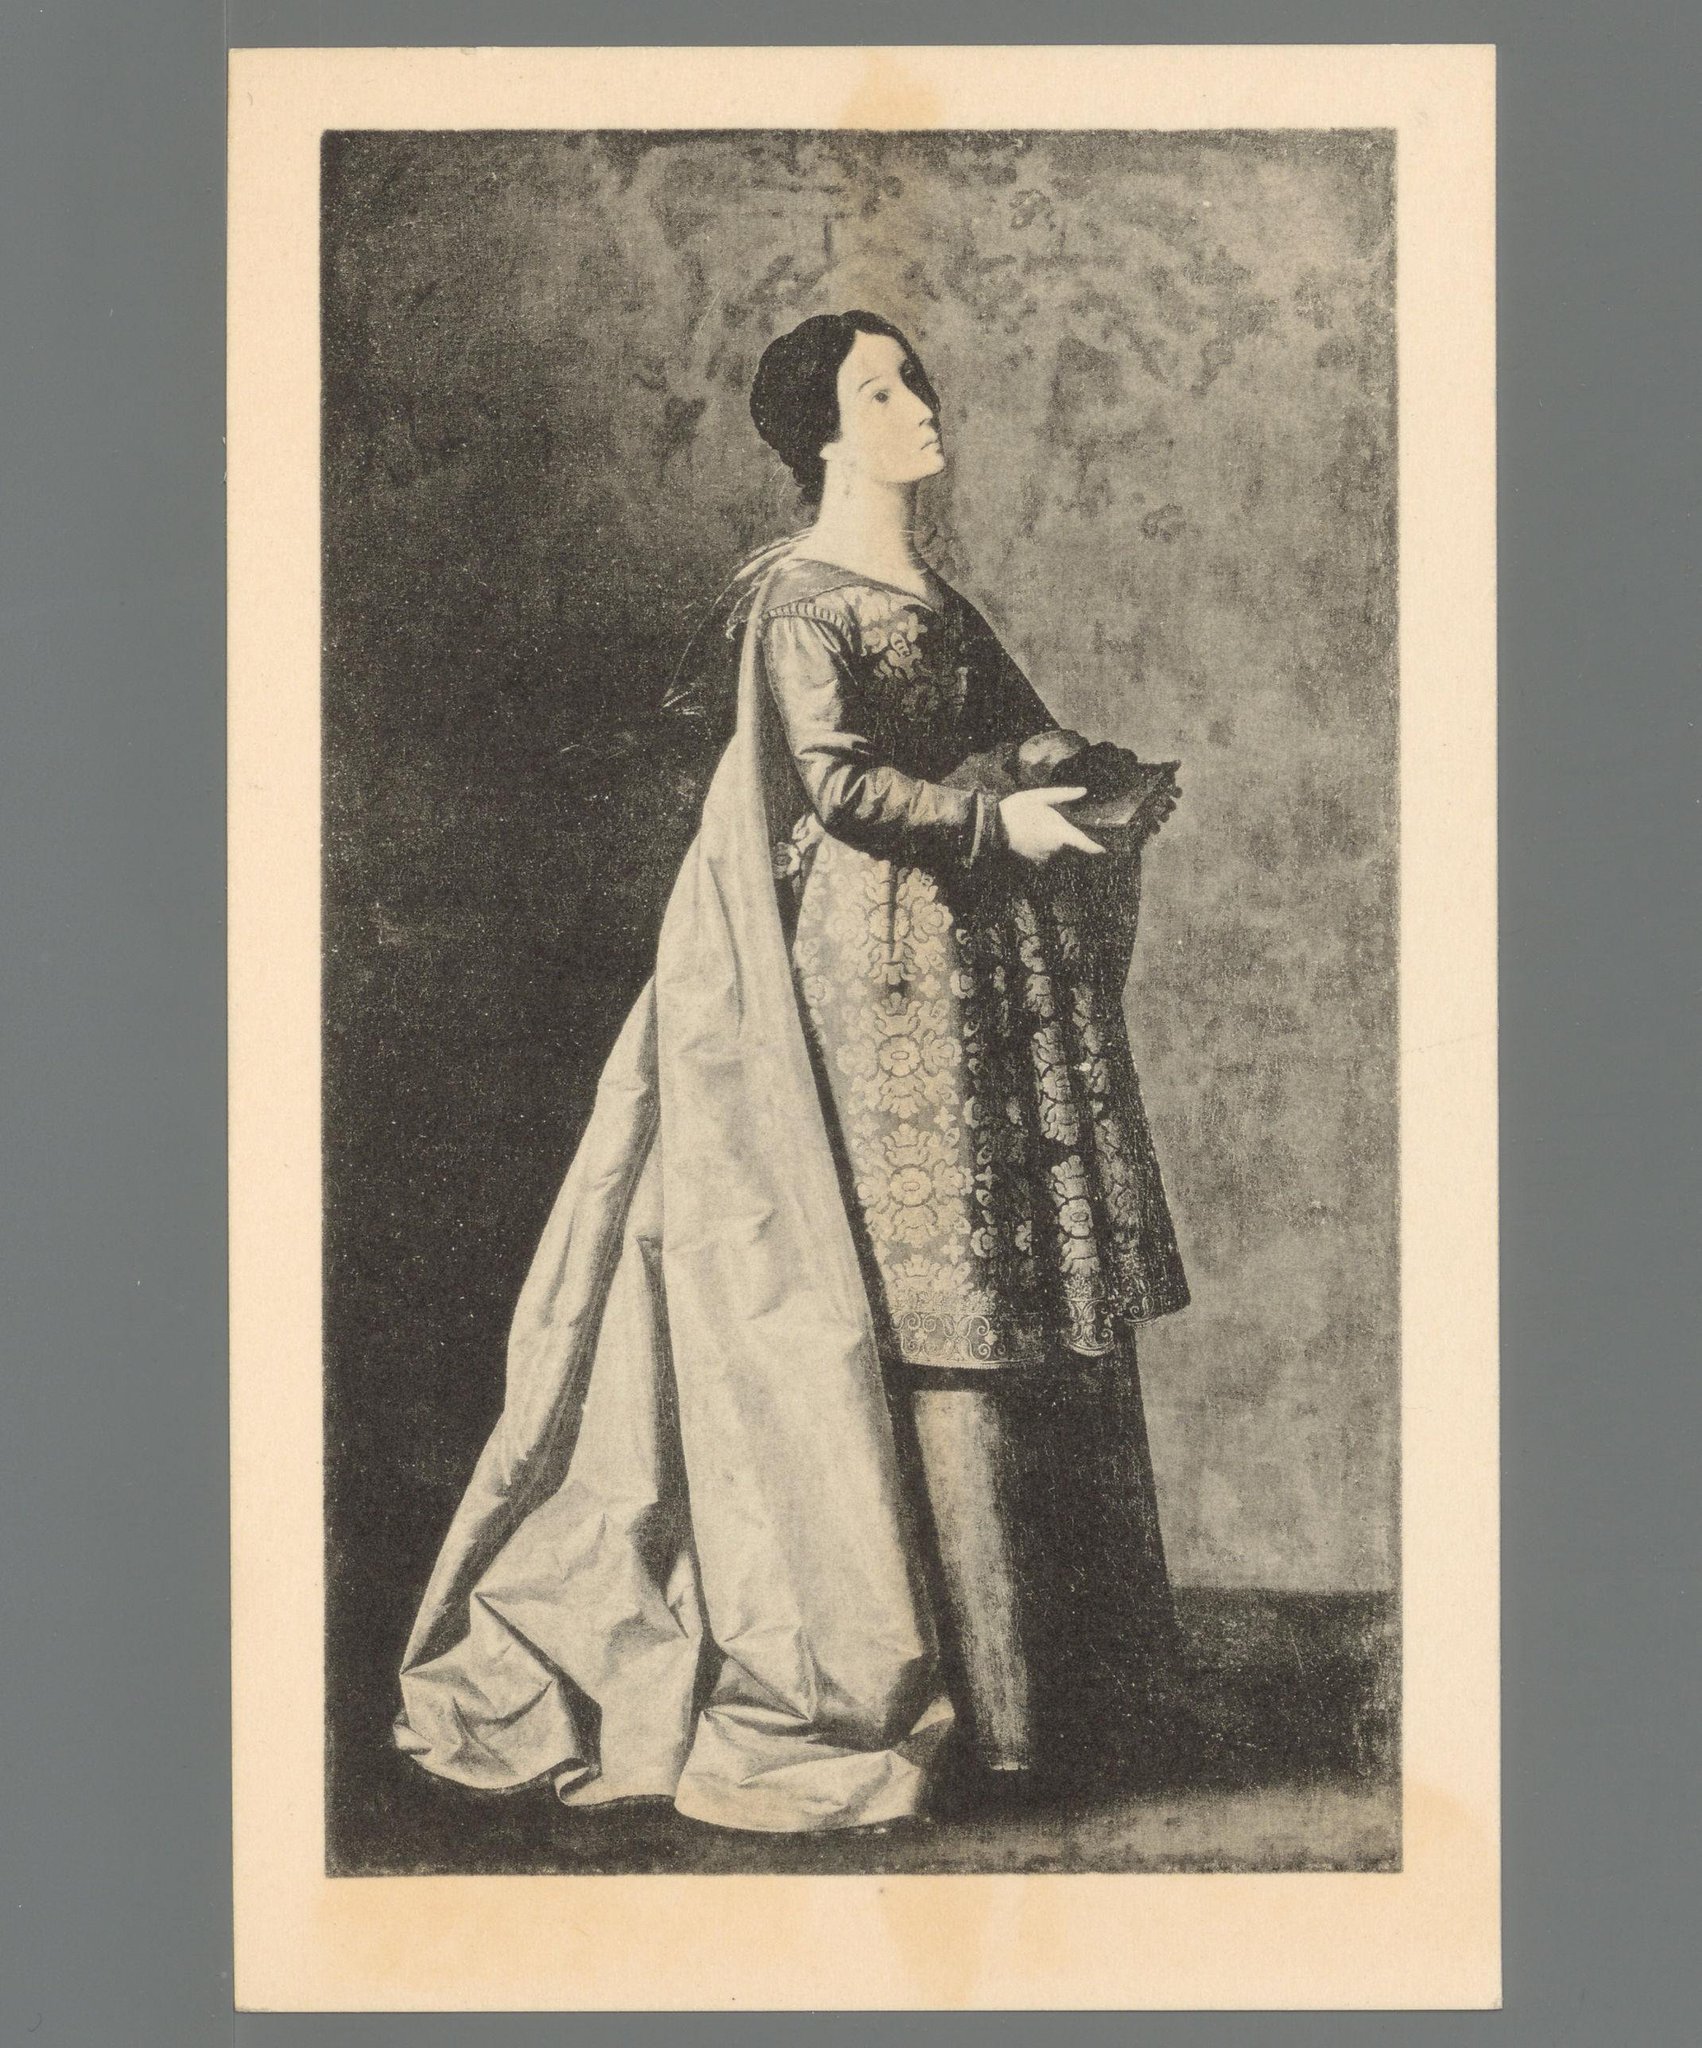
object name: photomechanical print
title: Saint Rufina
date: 1904-1940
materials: cardboard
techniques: photograph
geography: new york city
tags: female saints (with name), cape